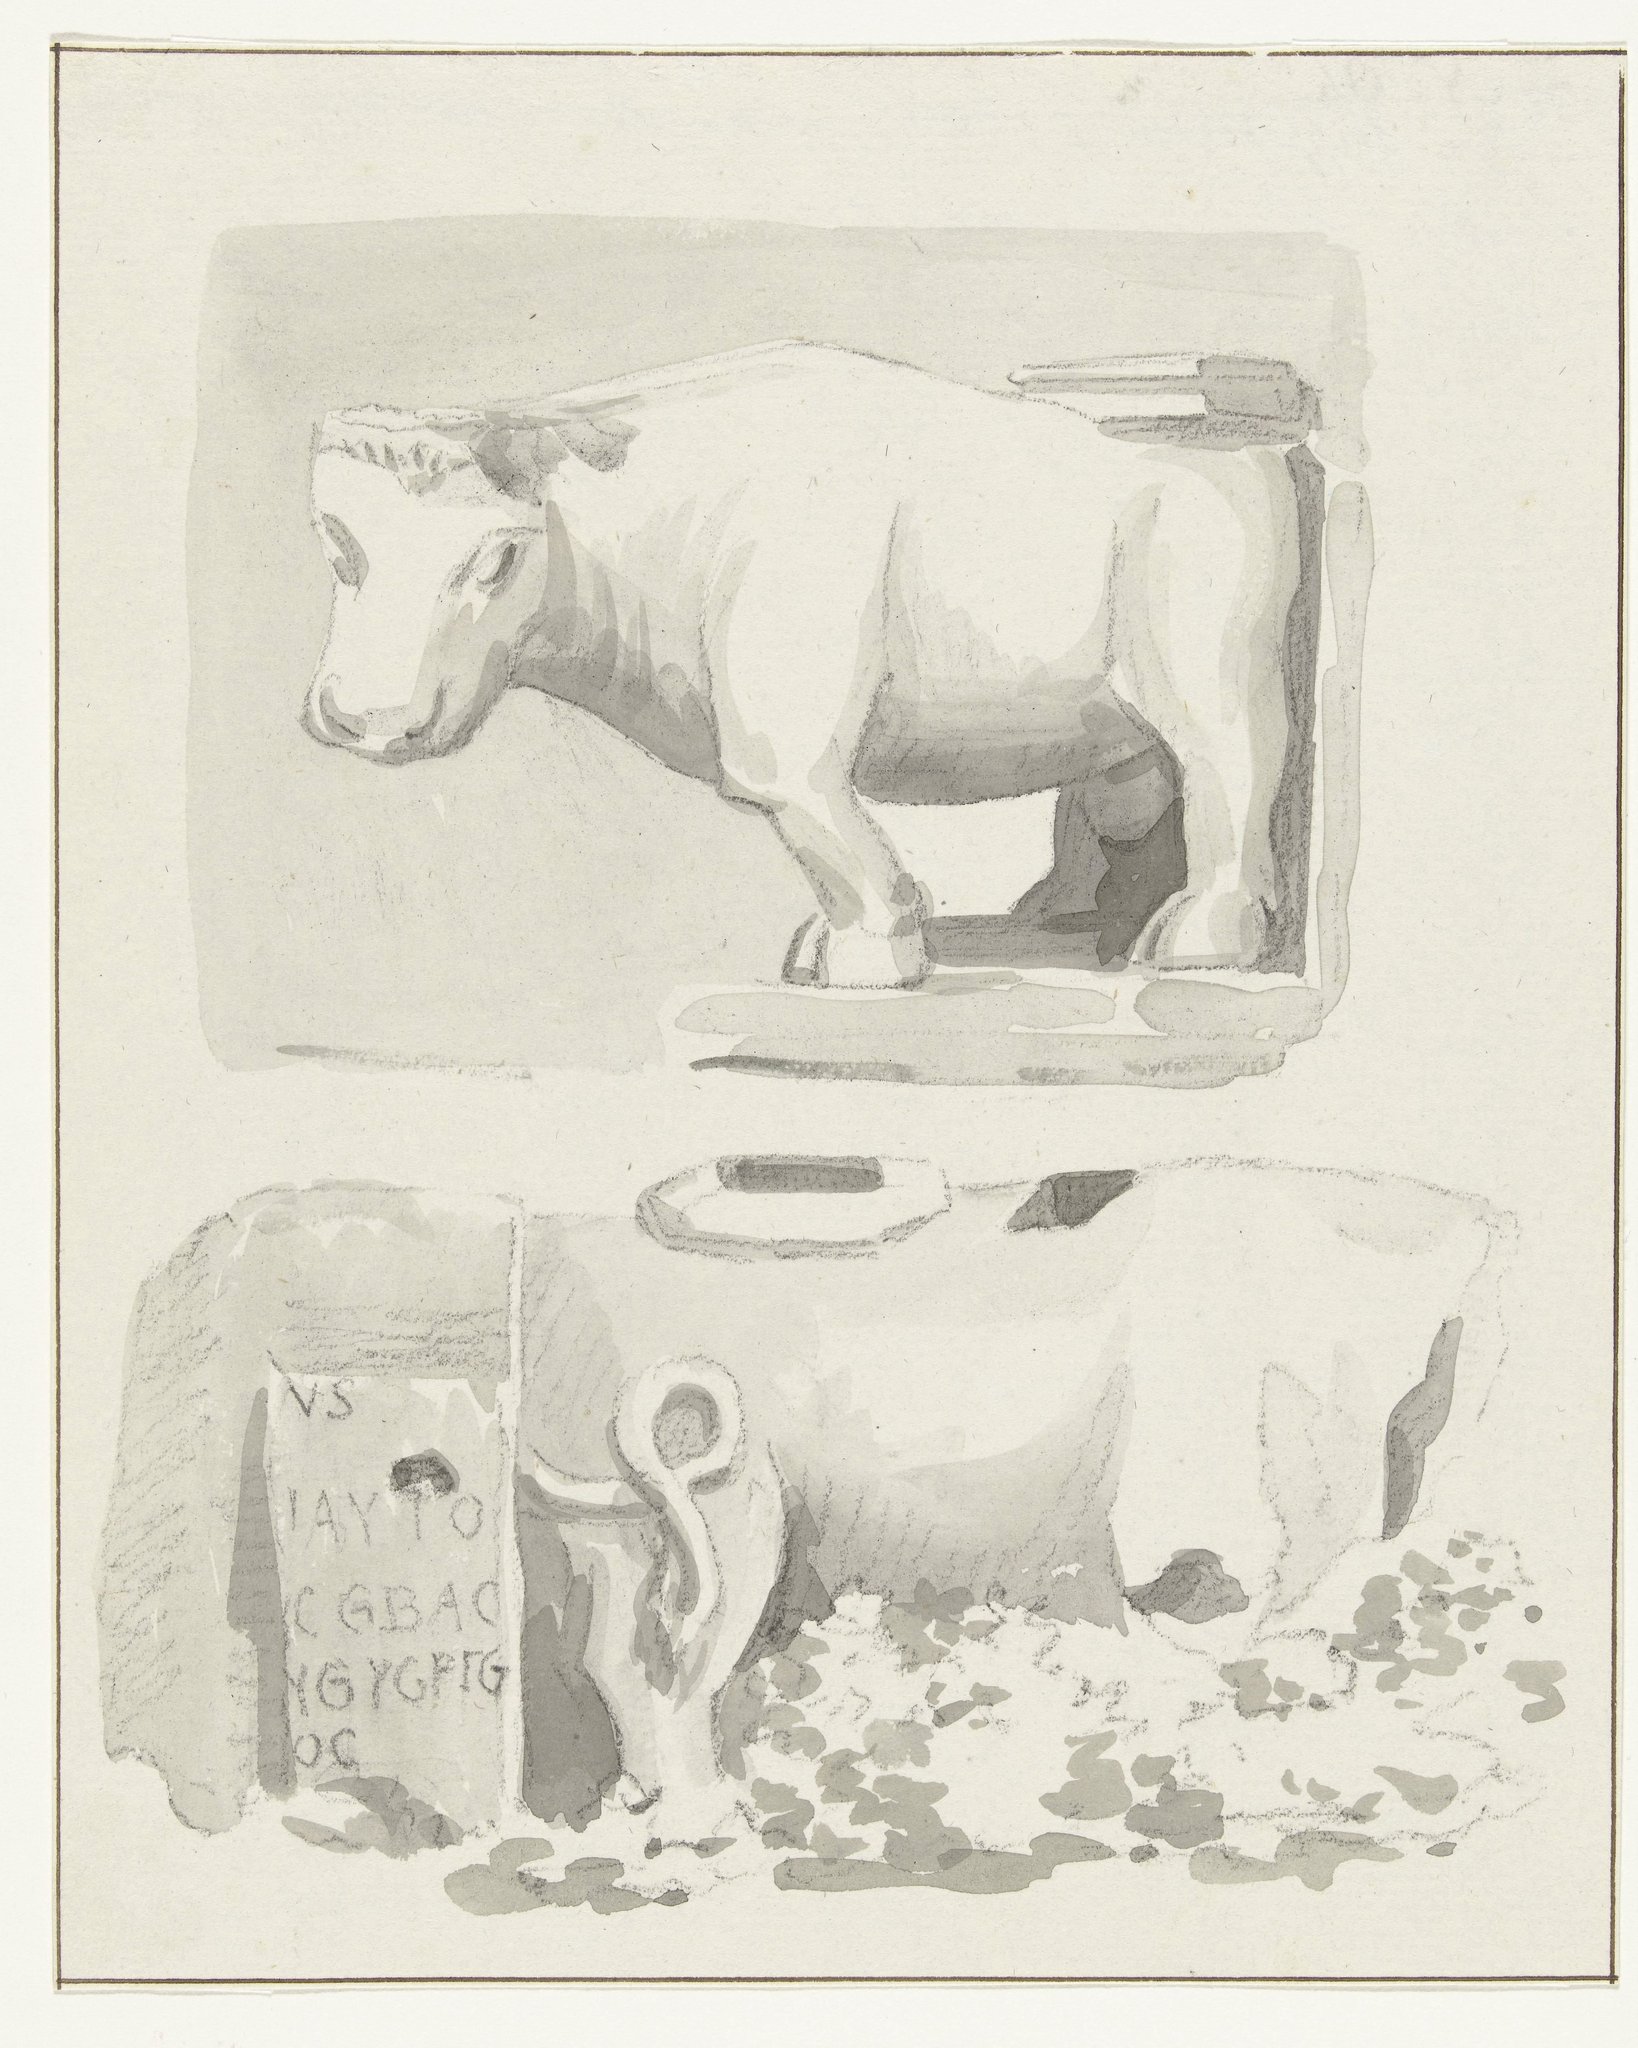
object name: drawing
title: Voyage en Italie, en Sicile et à Malte - 1778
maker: louis ducros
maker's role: draughtsman, print maker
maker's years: 1748-1810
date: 1778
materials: chalk, paper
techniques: brush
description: Tekening uit het album 'Voyage en Italie, en Sicile et à Malte', 1778.